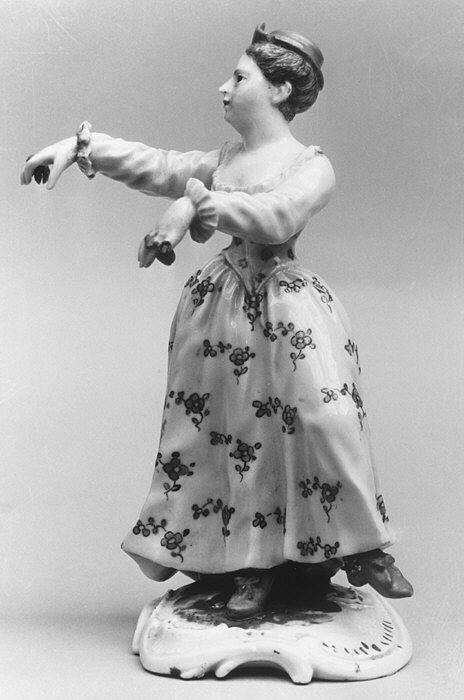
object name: figure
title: Dancer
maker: frankenthal porcelain manufactory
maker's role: manufactory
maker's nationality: german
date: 1757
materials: hard paste porcelain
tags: women,dancers